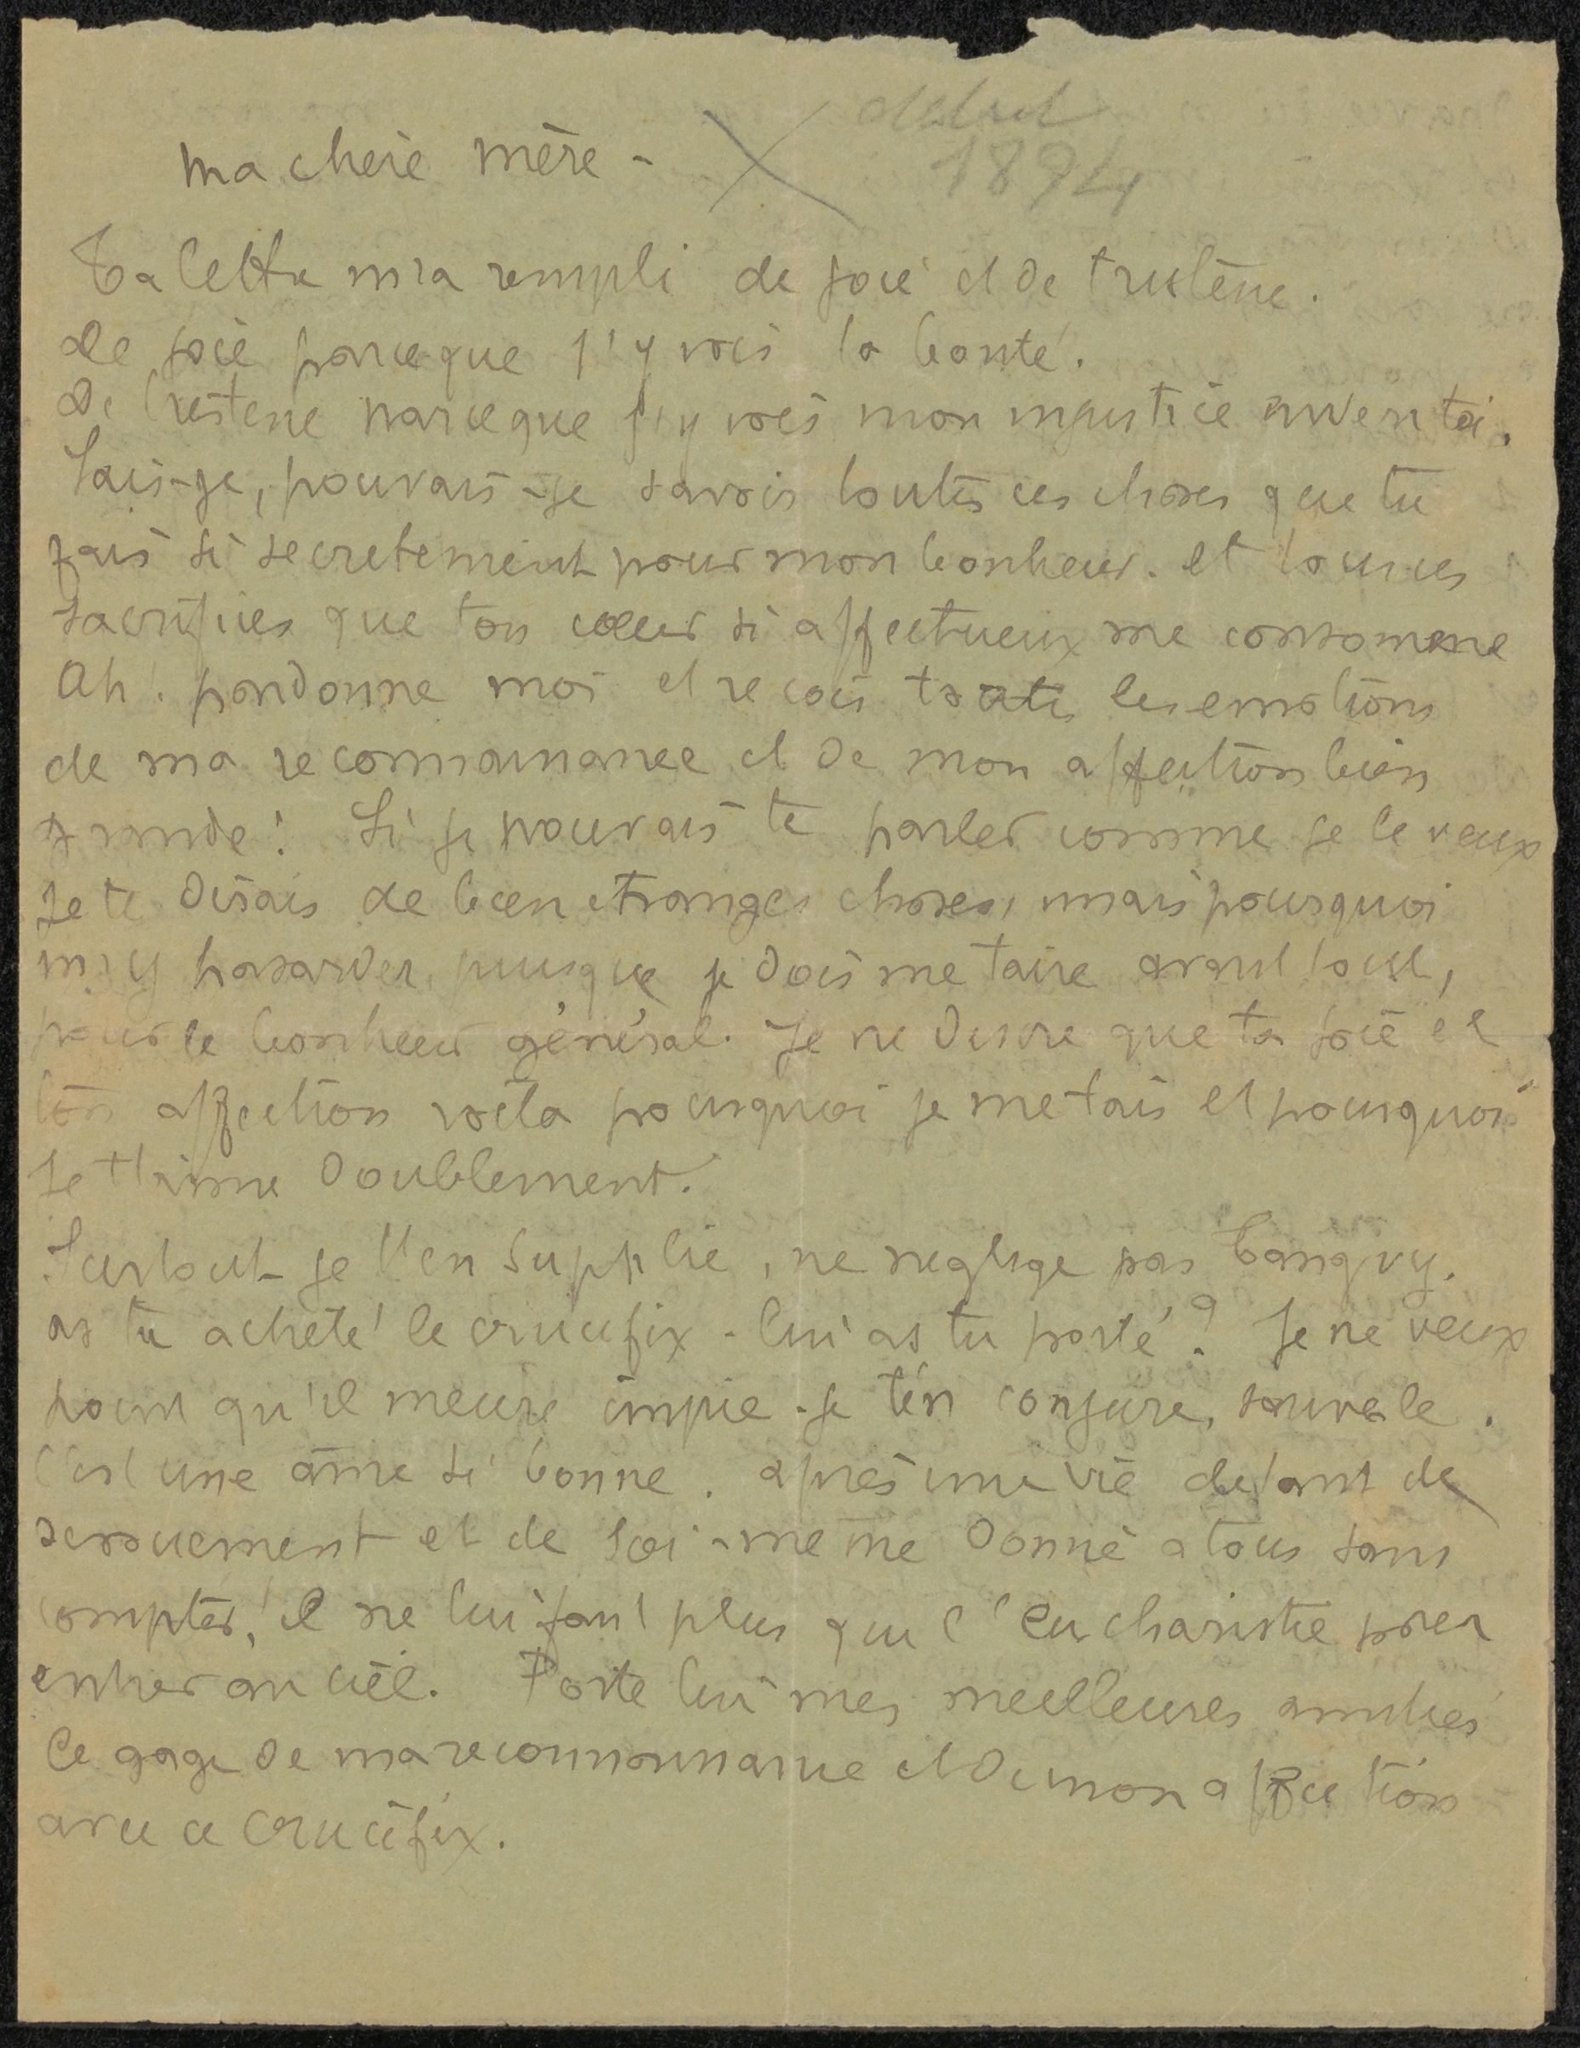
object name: letter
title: Brief aan Héloïse Bernard-Bodin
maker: émile bernard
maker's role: print maker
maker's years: 1868-1941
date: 1801-1894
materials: ink, paper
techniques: pen, writing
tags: draughtsman, odilon redon, amsterdam, andries bonger, publisher, henri louis ambroise vollard, christian religion, money